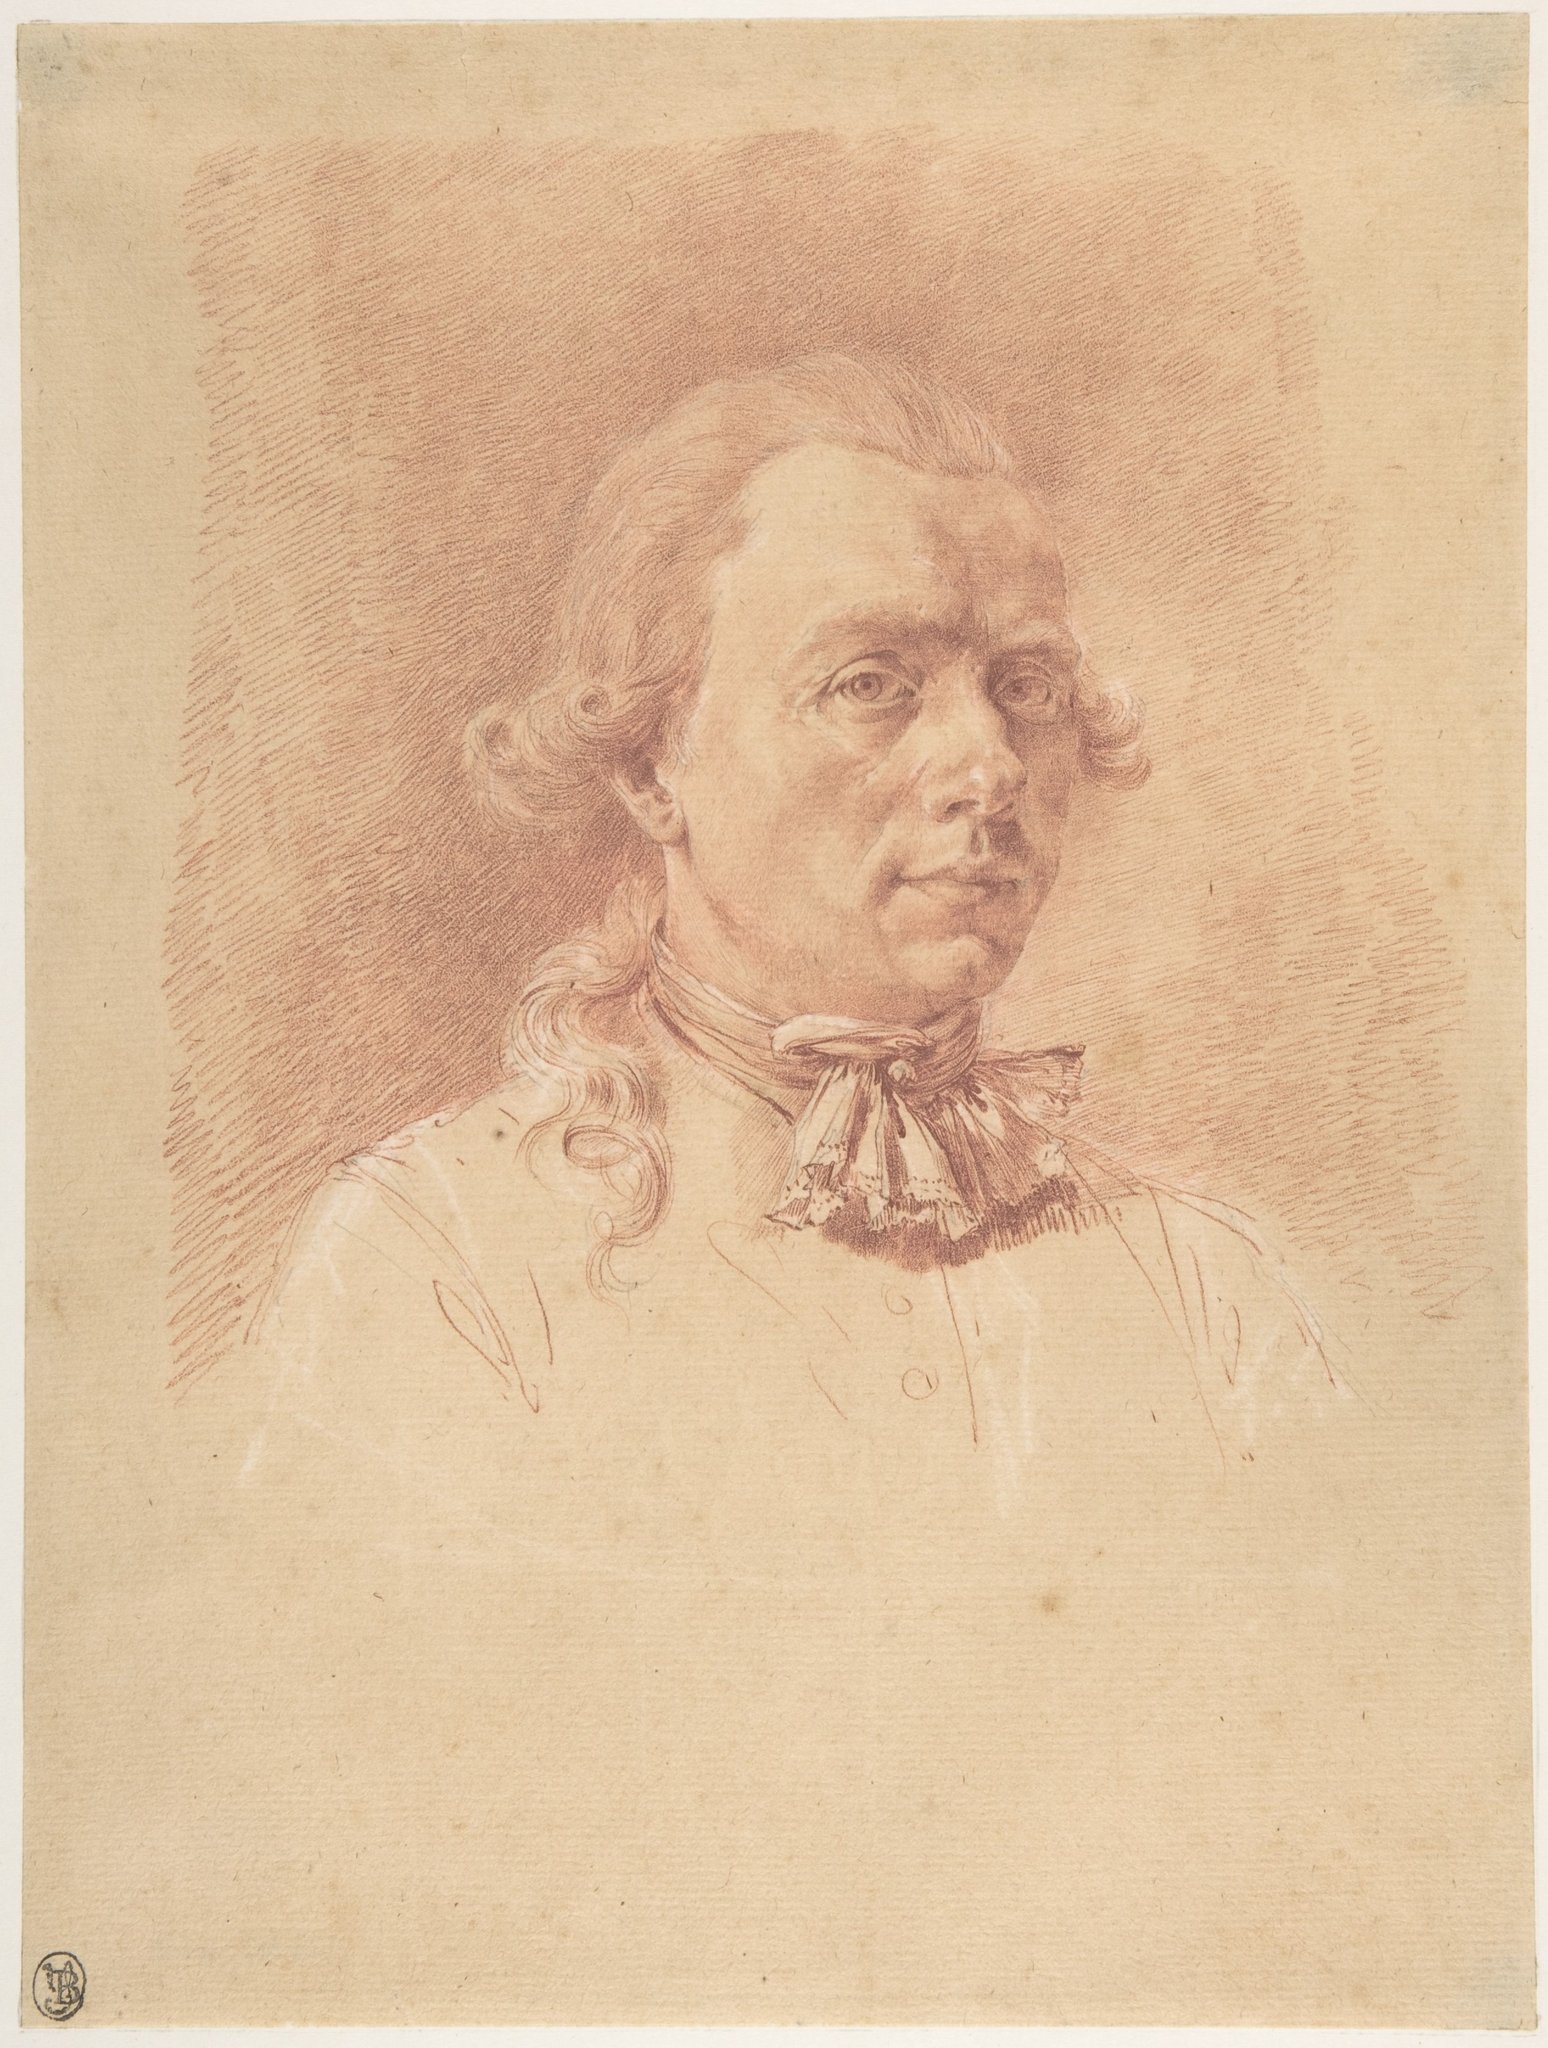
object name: drawing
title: Self-Portrait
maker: jean jacques de boissieu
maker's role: artist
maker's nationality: french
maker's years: 1736-1810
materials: chalk, graphite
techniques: heightening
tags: men,self-portraits